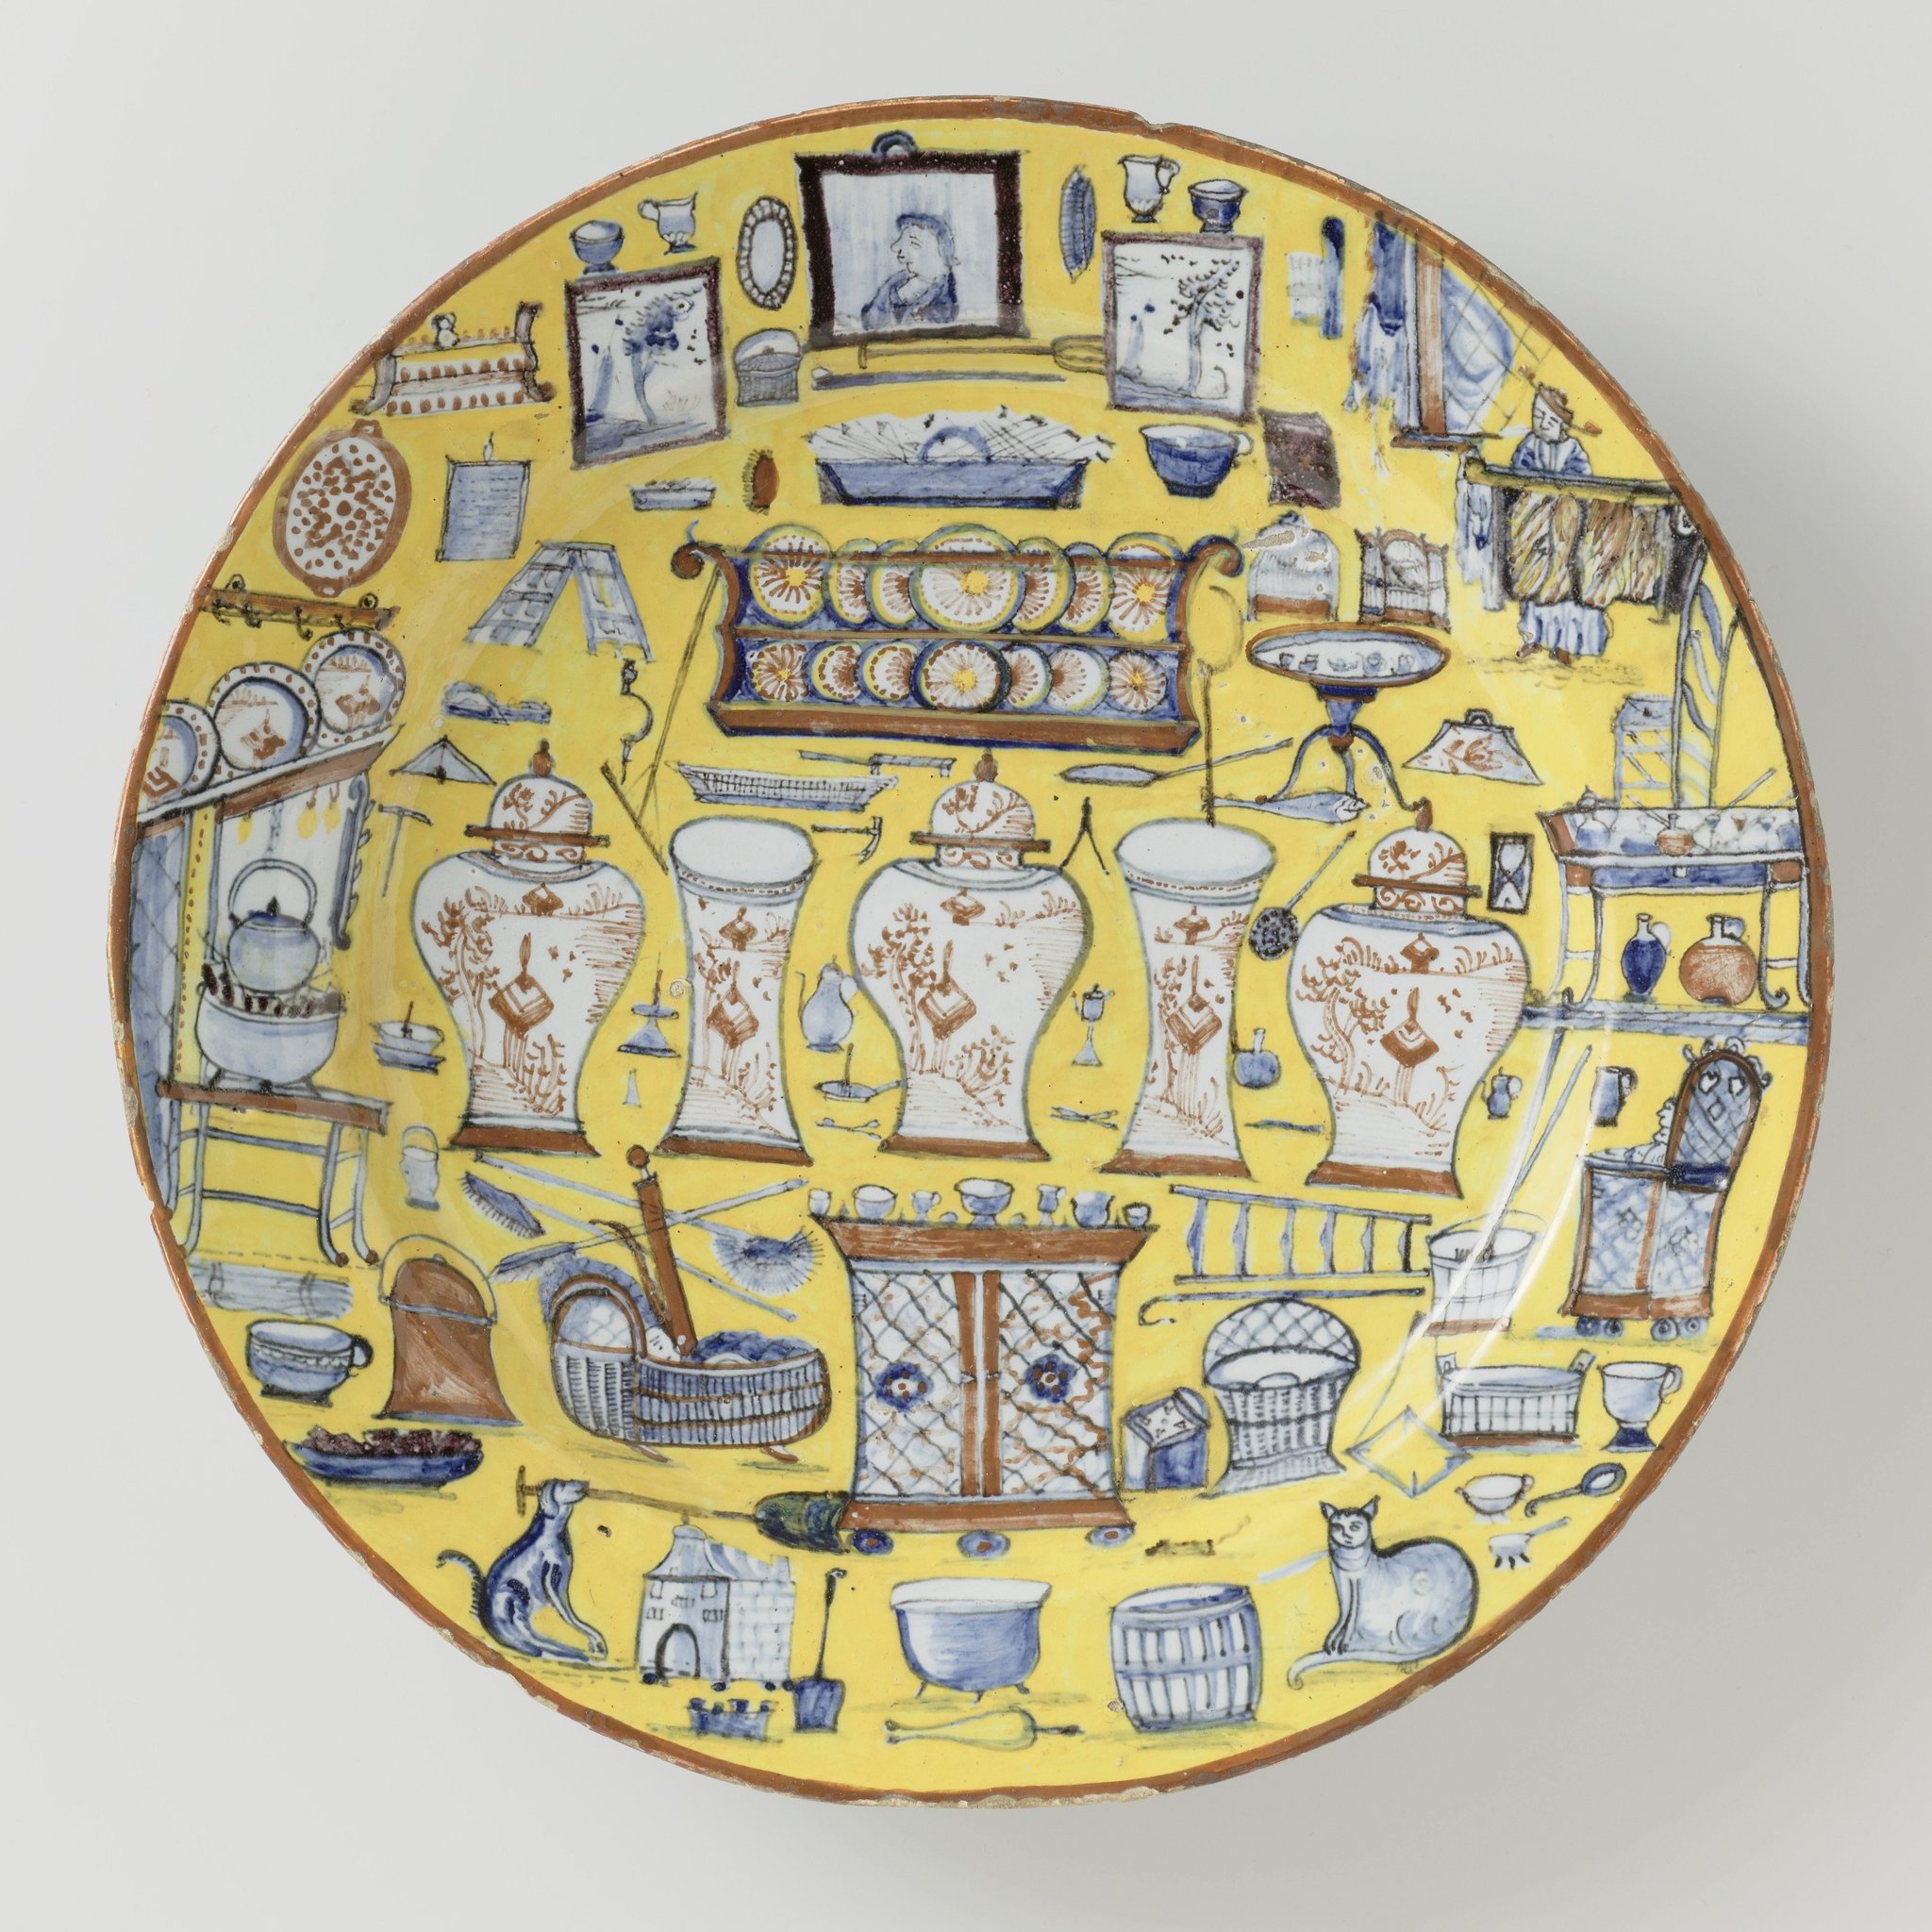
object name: platter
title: Charger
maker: Anonymous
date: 1750-1775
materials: earthenware, glaze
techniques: painted, polychromy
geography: delft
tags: furniture and household effects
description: This large dish with a striking yellow ground is painted with all kinds of household objects, including a tea table, a garniture of vases and an earthenware fish strainer, plus brooms, paintings and bird cages. It looks like an advertisement for the stock of a shop! Decorations with many individual objects are also known from Asian art. Dishes painted with such ornament probably served as models for this plate.